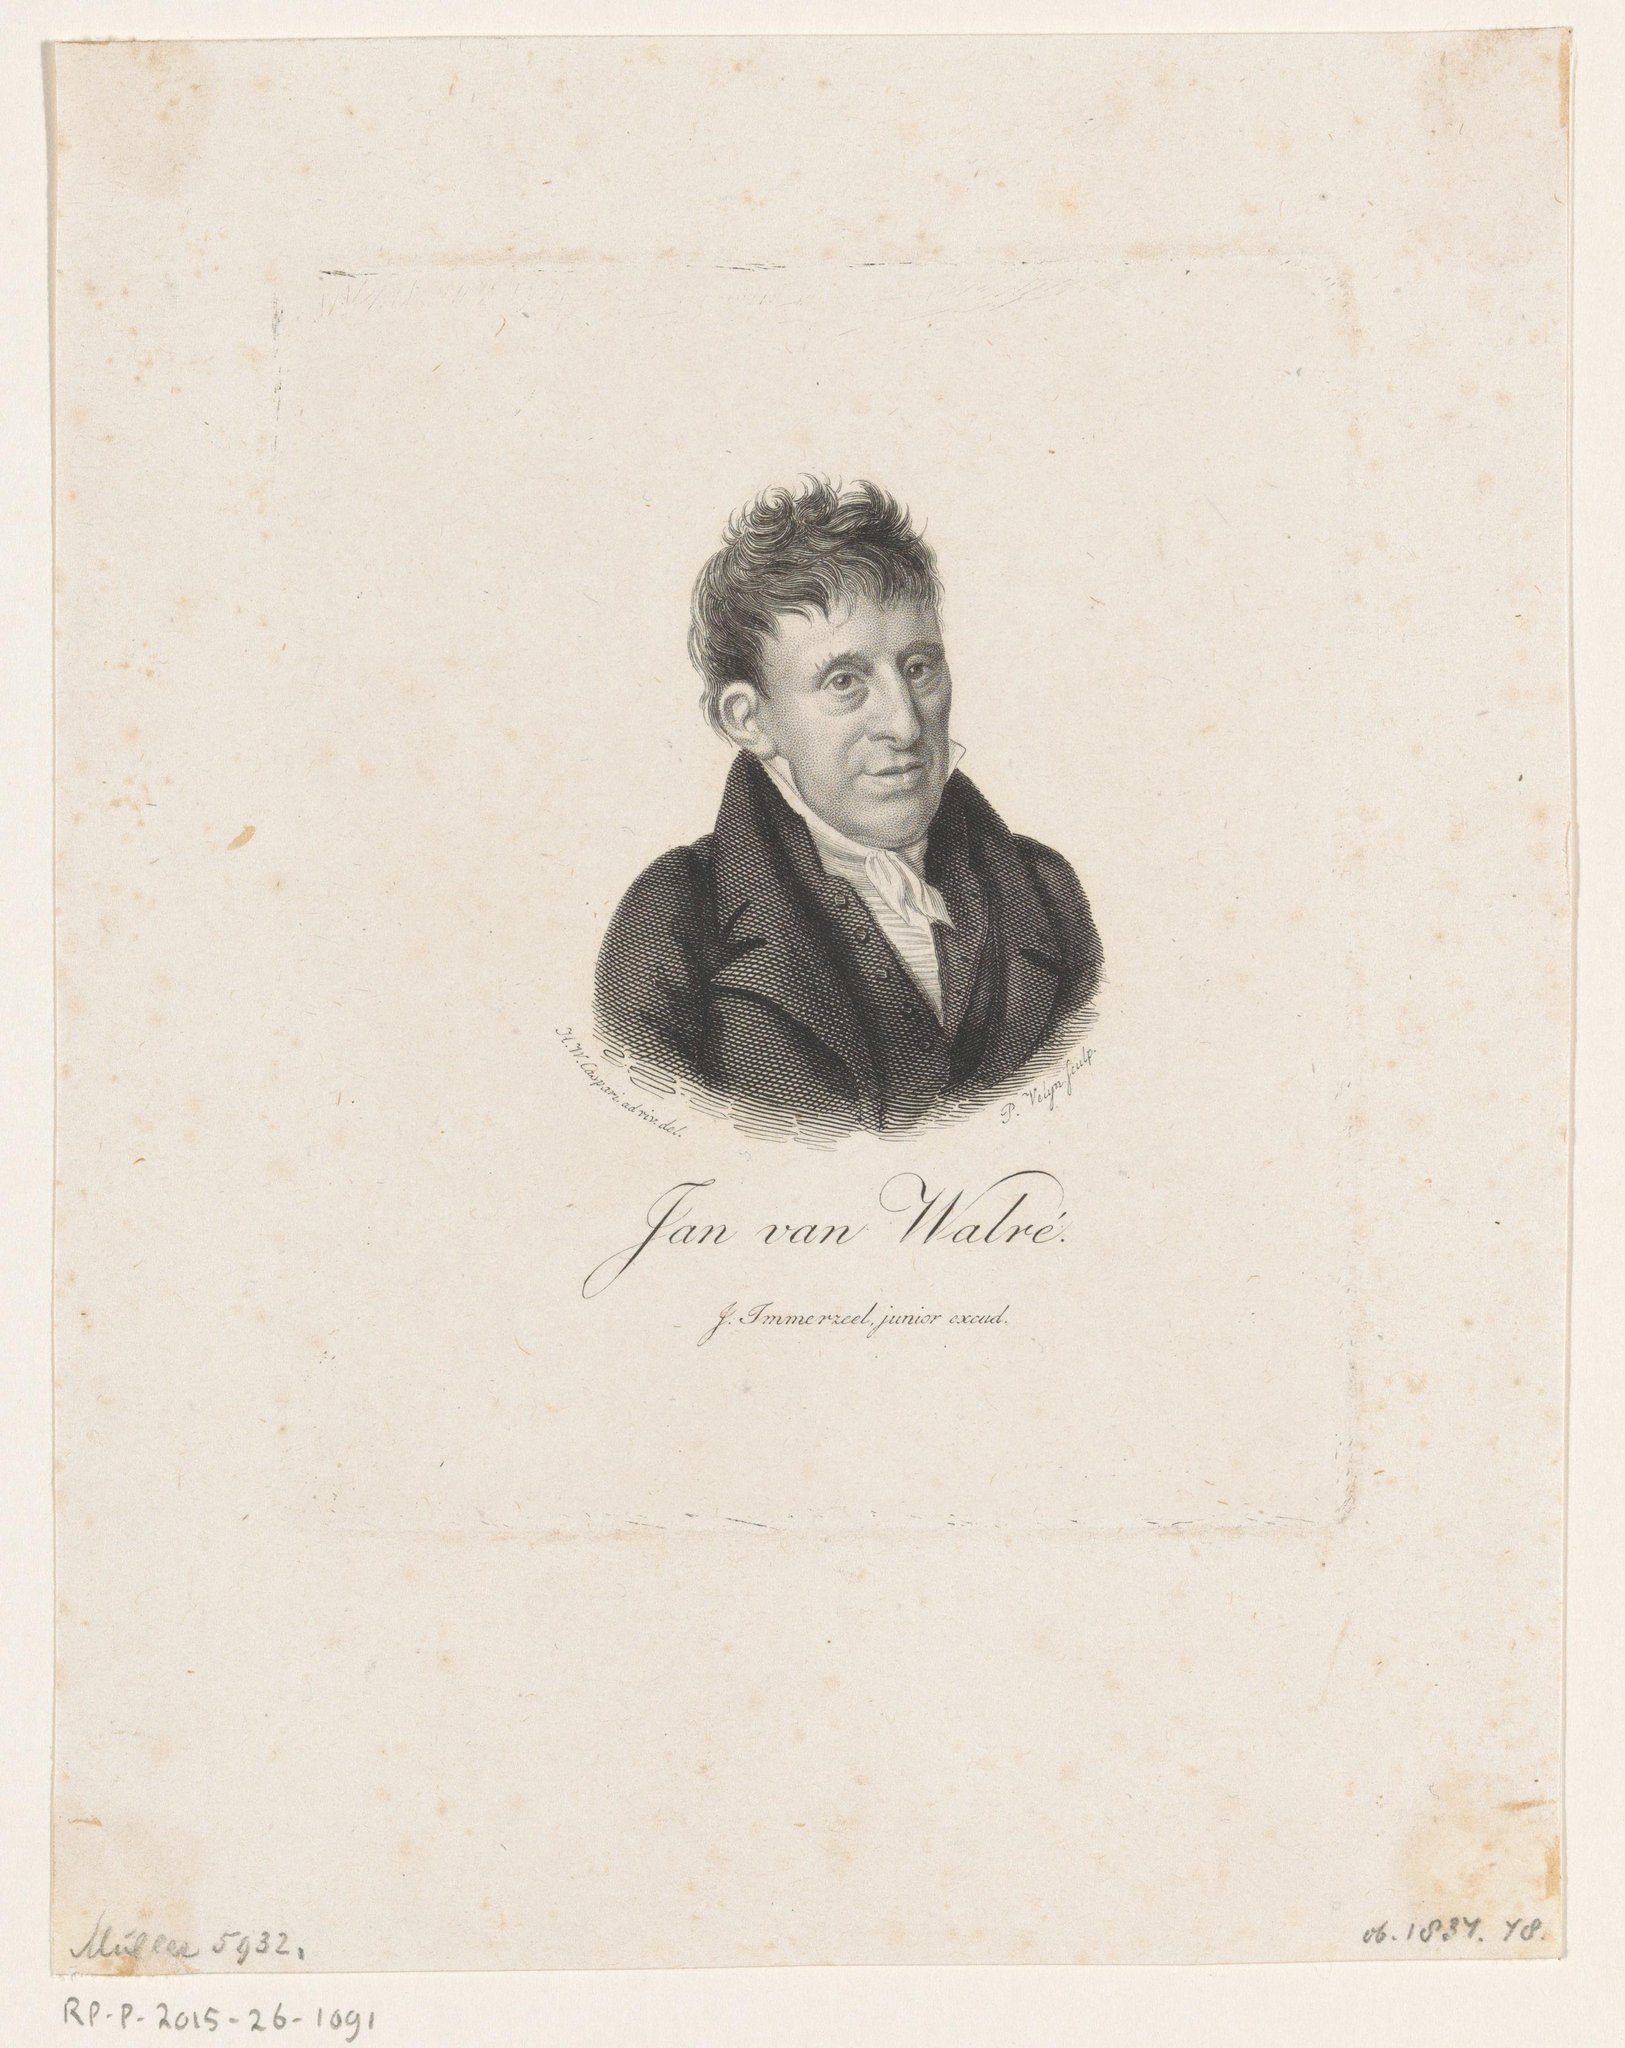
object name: print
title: Portret van Jan van Walré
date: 1826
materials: paper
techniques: engraving, etching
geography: netherlands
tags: haarlem, publisher, jan van walré, publishing, publisher, writer, poet, author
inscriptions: collector's mark: Lugt 2228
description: Prent volgens Van Someren ook gebruikt in: Nederlandsche Muzen-Almanak. Rotterdam: J. Immerzeel, 1826.